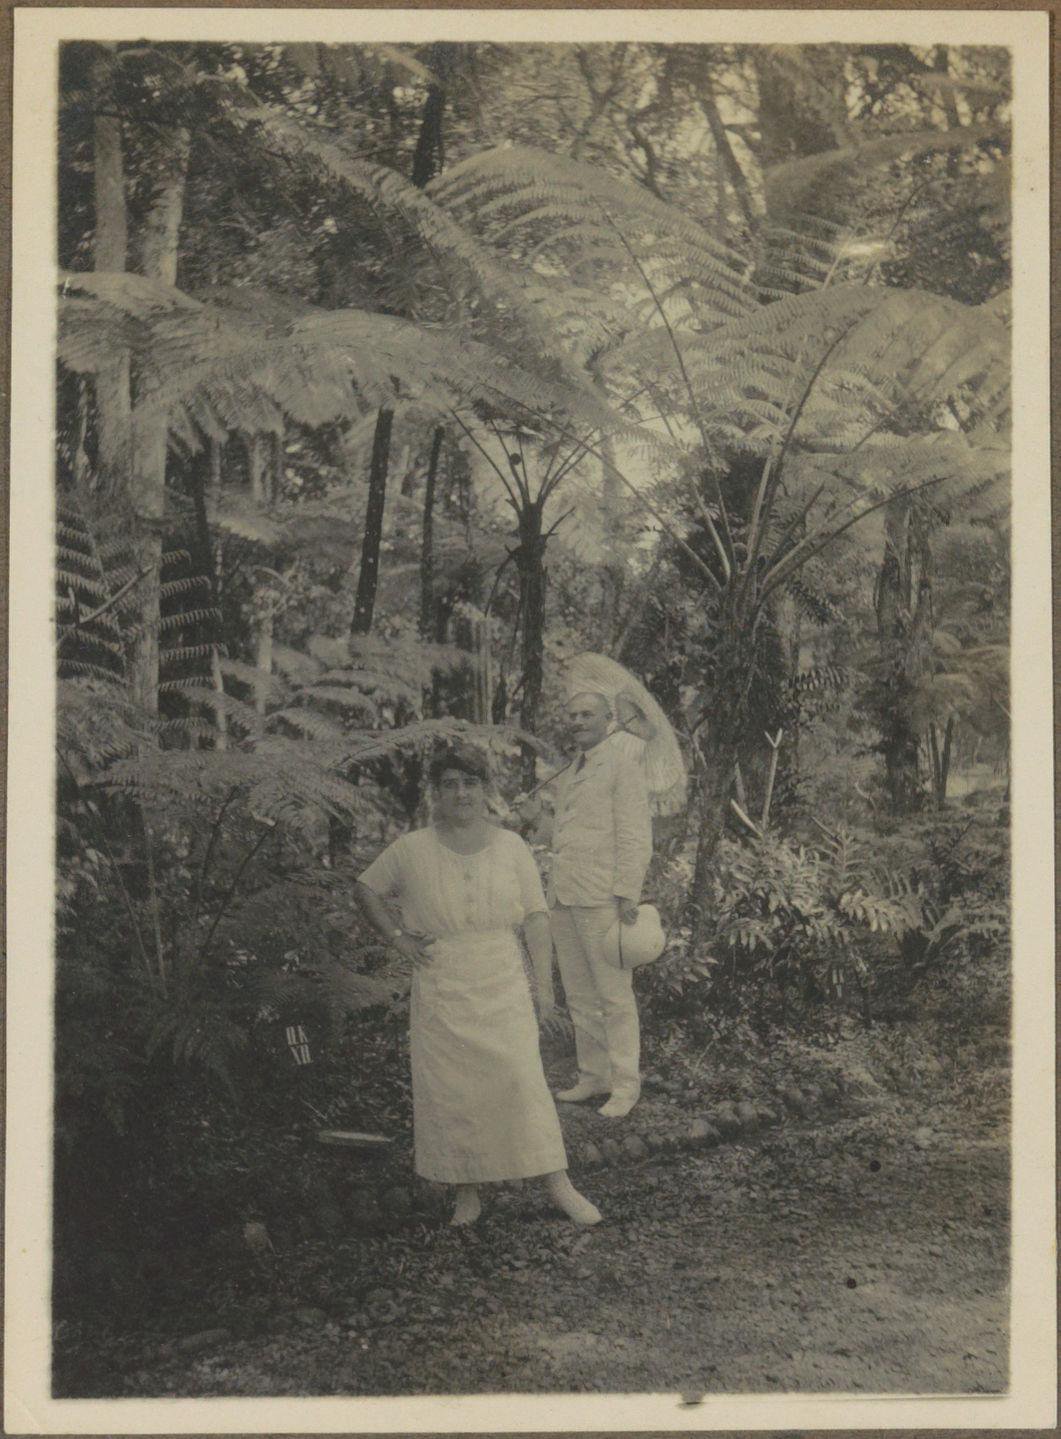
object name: photograph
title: 'N zachte zitplaats!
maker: Anonymous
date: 1920-1930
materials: photographic support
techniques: gelatin silver print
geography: dutch east indies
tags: adult woman, adult man, boulder, stone, dutch east indies, the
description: Onderdeel van fotoalbum van een onbekende Nederlandse familie met opnames van Suriname, Europa en Nederlands-Indië.